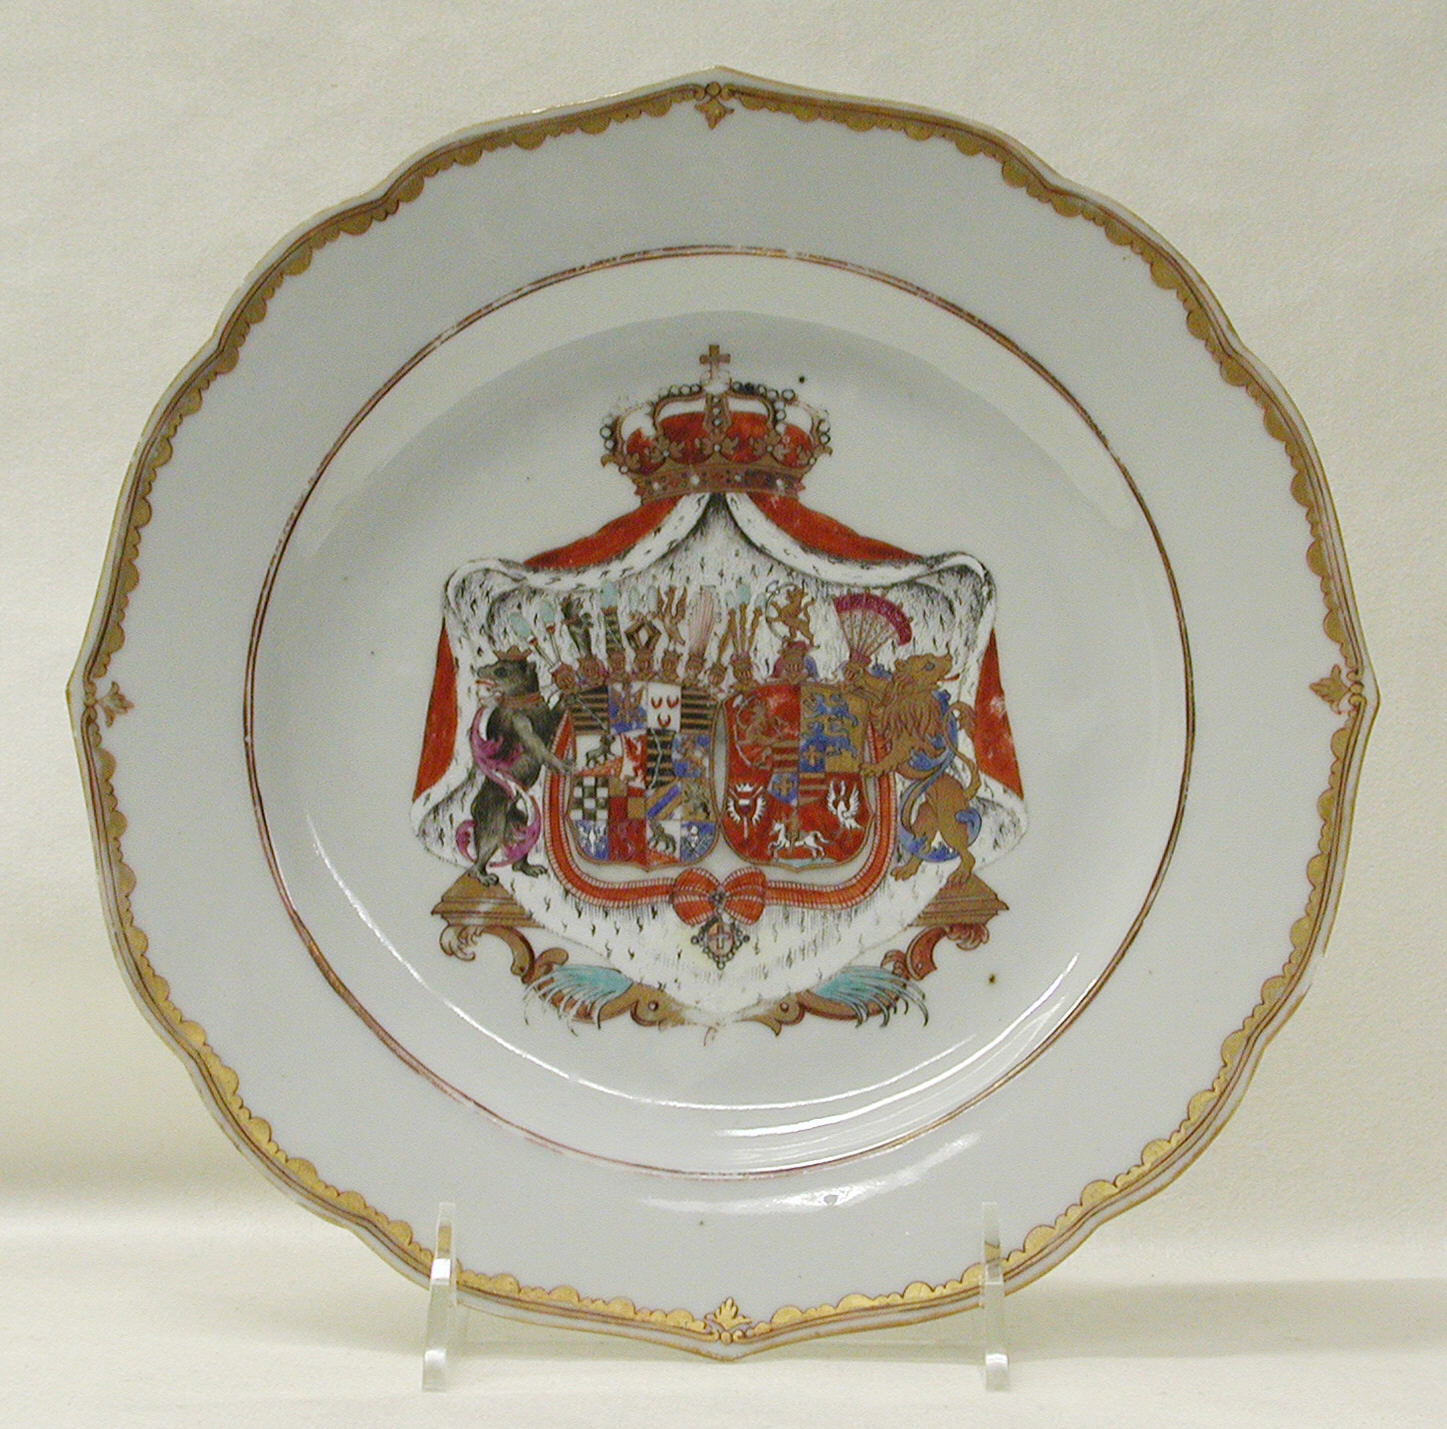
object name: plate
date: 1734-1766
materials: hard paste porcelain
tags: coat of arms